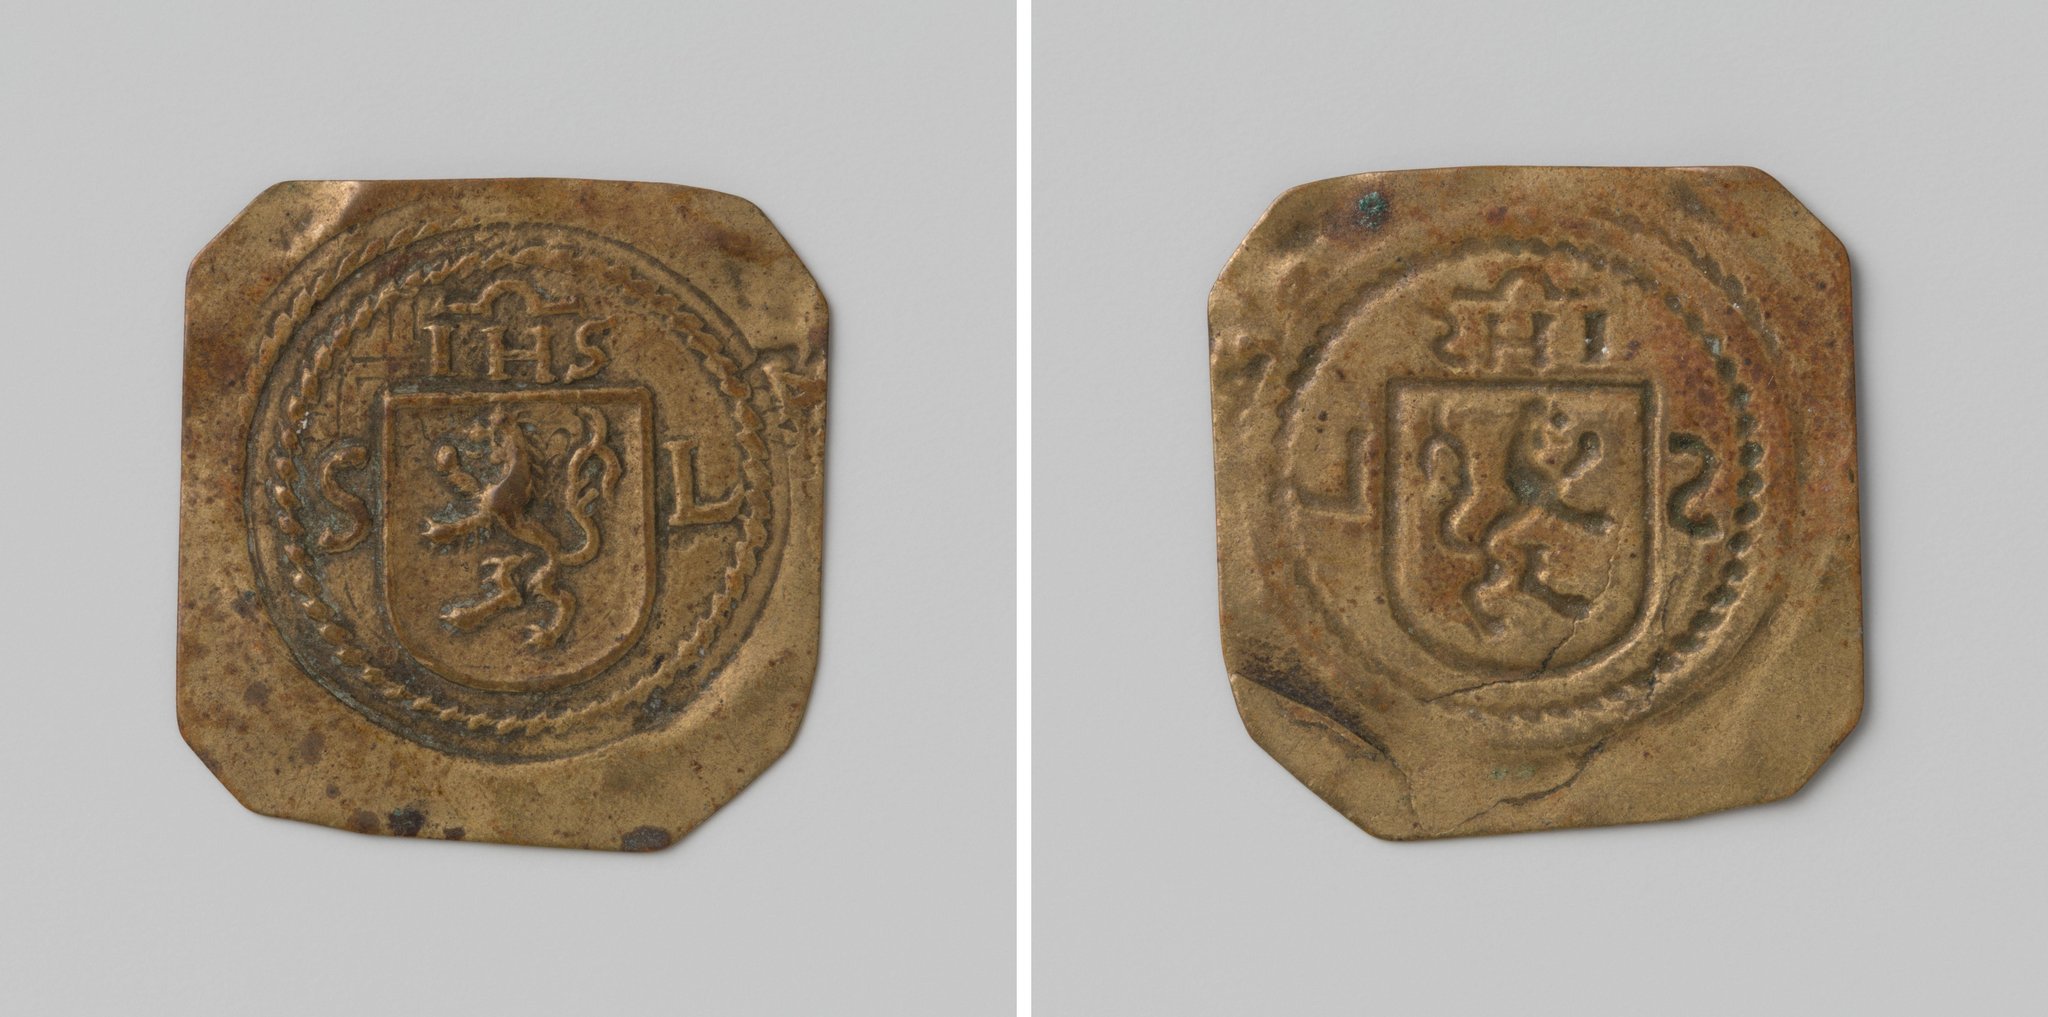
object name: armenloodje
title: Boelema-gasthuis te Leeuwarden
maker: Anonymous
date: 1600-1800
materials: brass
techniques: striking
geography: leeuwarden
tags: leeuwarden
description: Eenzijdig messing vierkant loodje met afgeschuinde hoeken. Voorzijde: in ronde stempel: wapenschild onder opschrift tussen letters S en L binnen kabelrand; rechts, in kabelrand: cijfer 4. Keerzijde: blanco